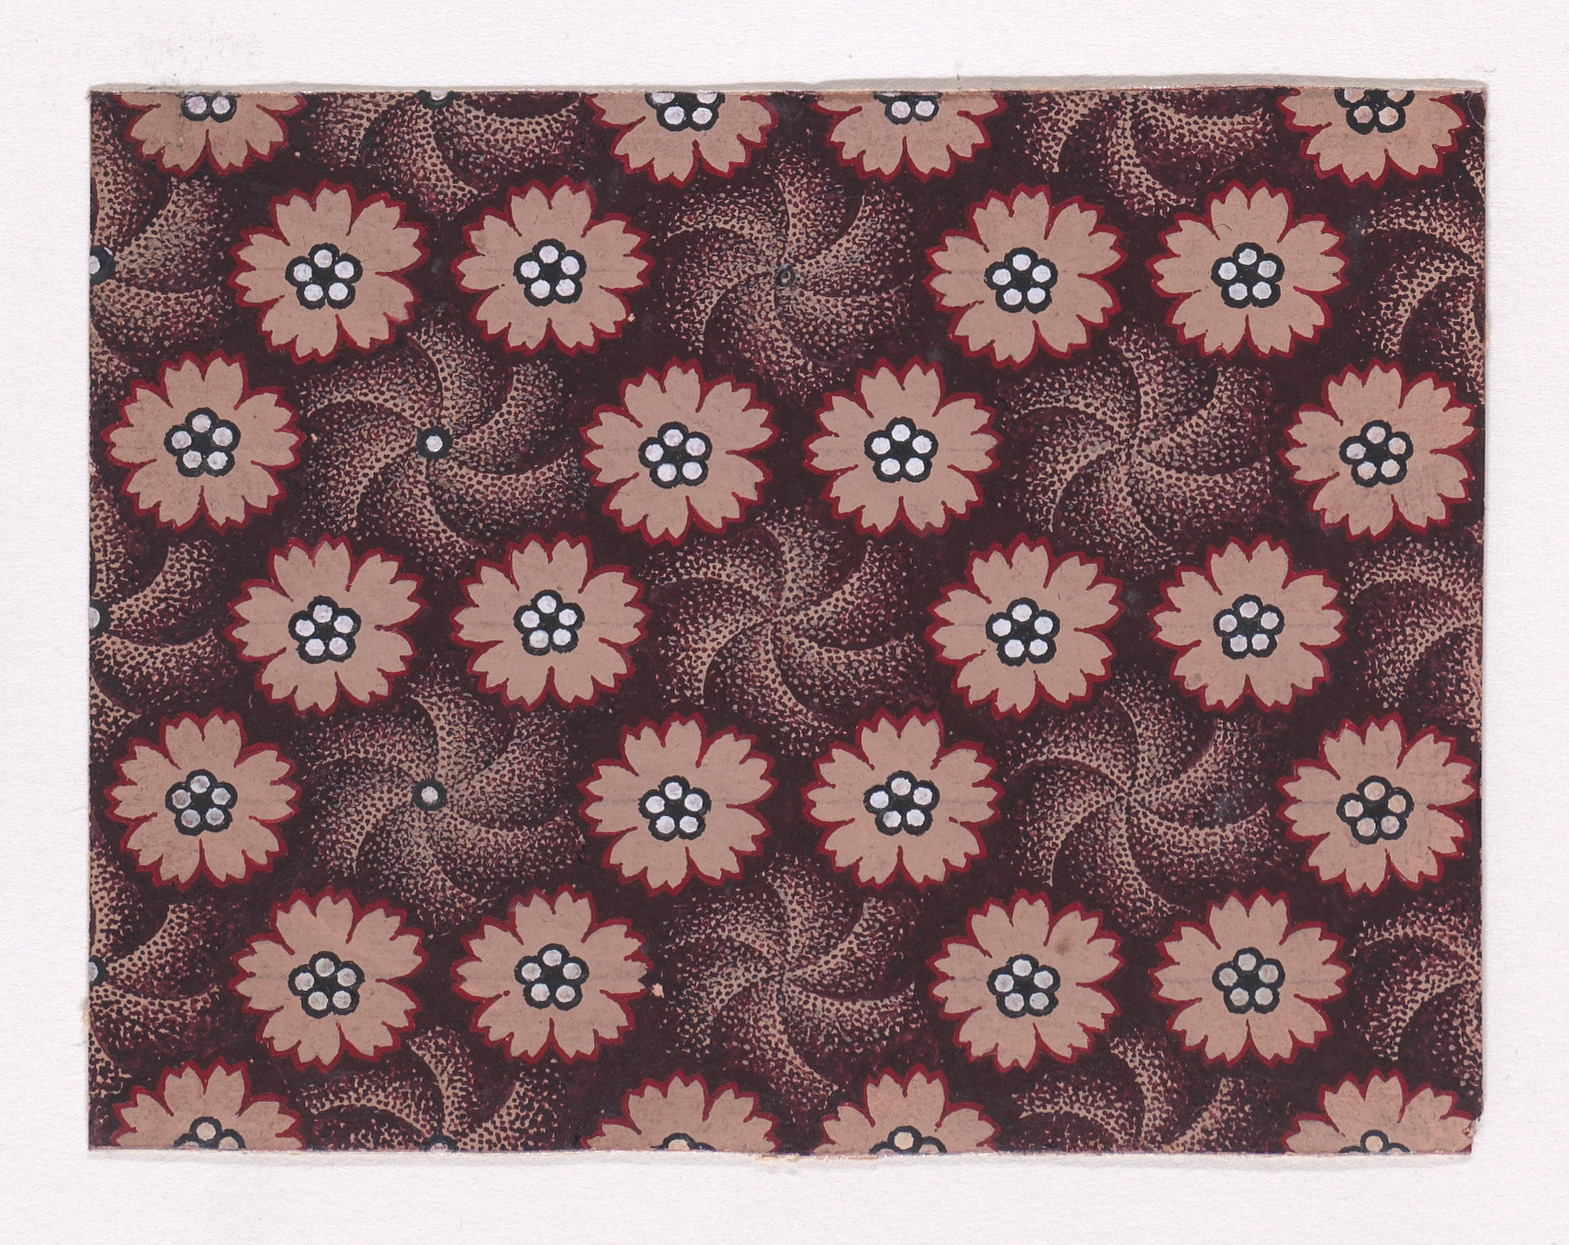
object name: drawing ornament architecture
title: Textile Design with Rosettes Forming Hexagonal Shapes Around Swirls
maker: anonymous, alsatian, 19th century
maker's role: artist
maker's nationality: alsatian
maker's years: 1800-1900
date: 1840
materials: gouache